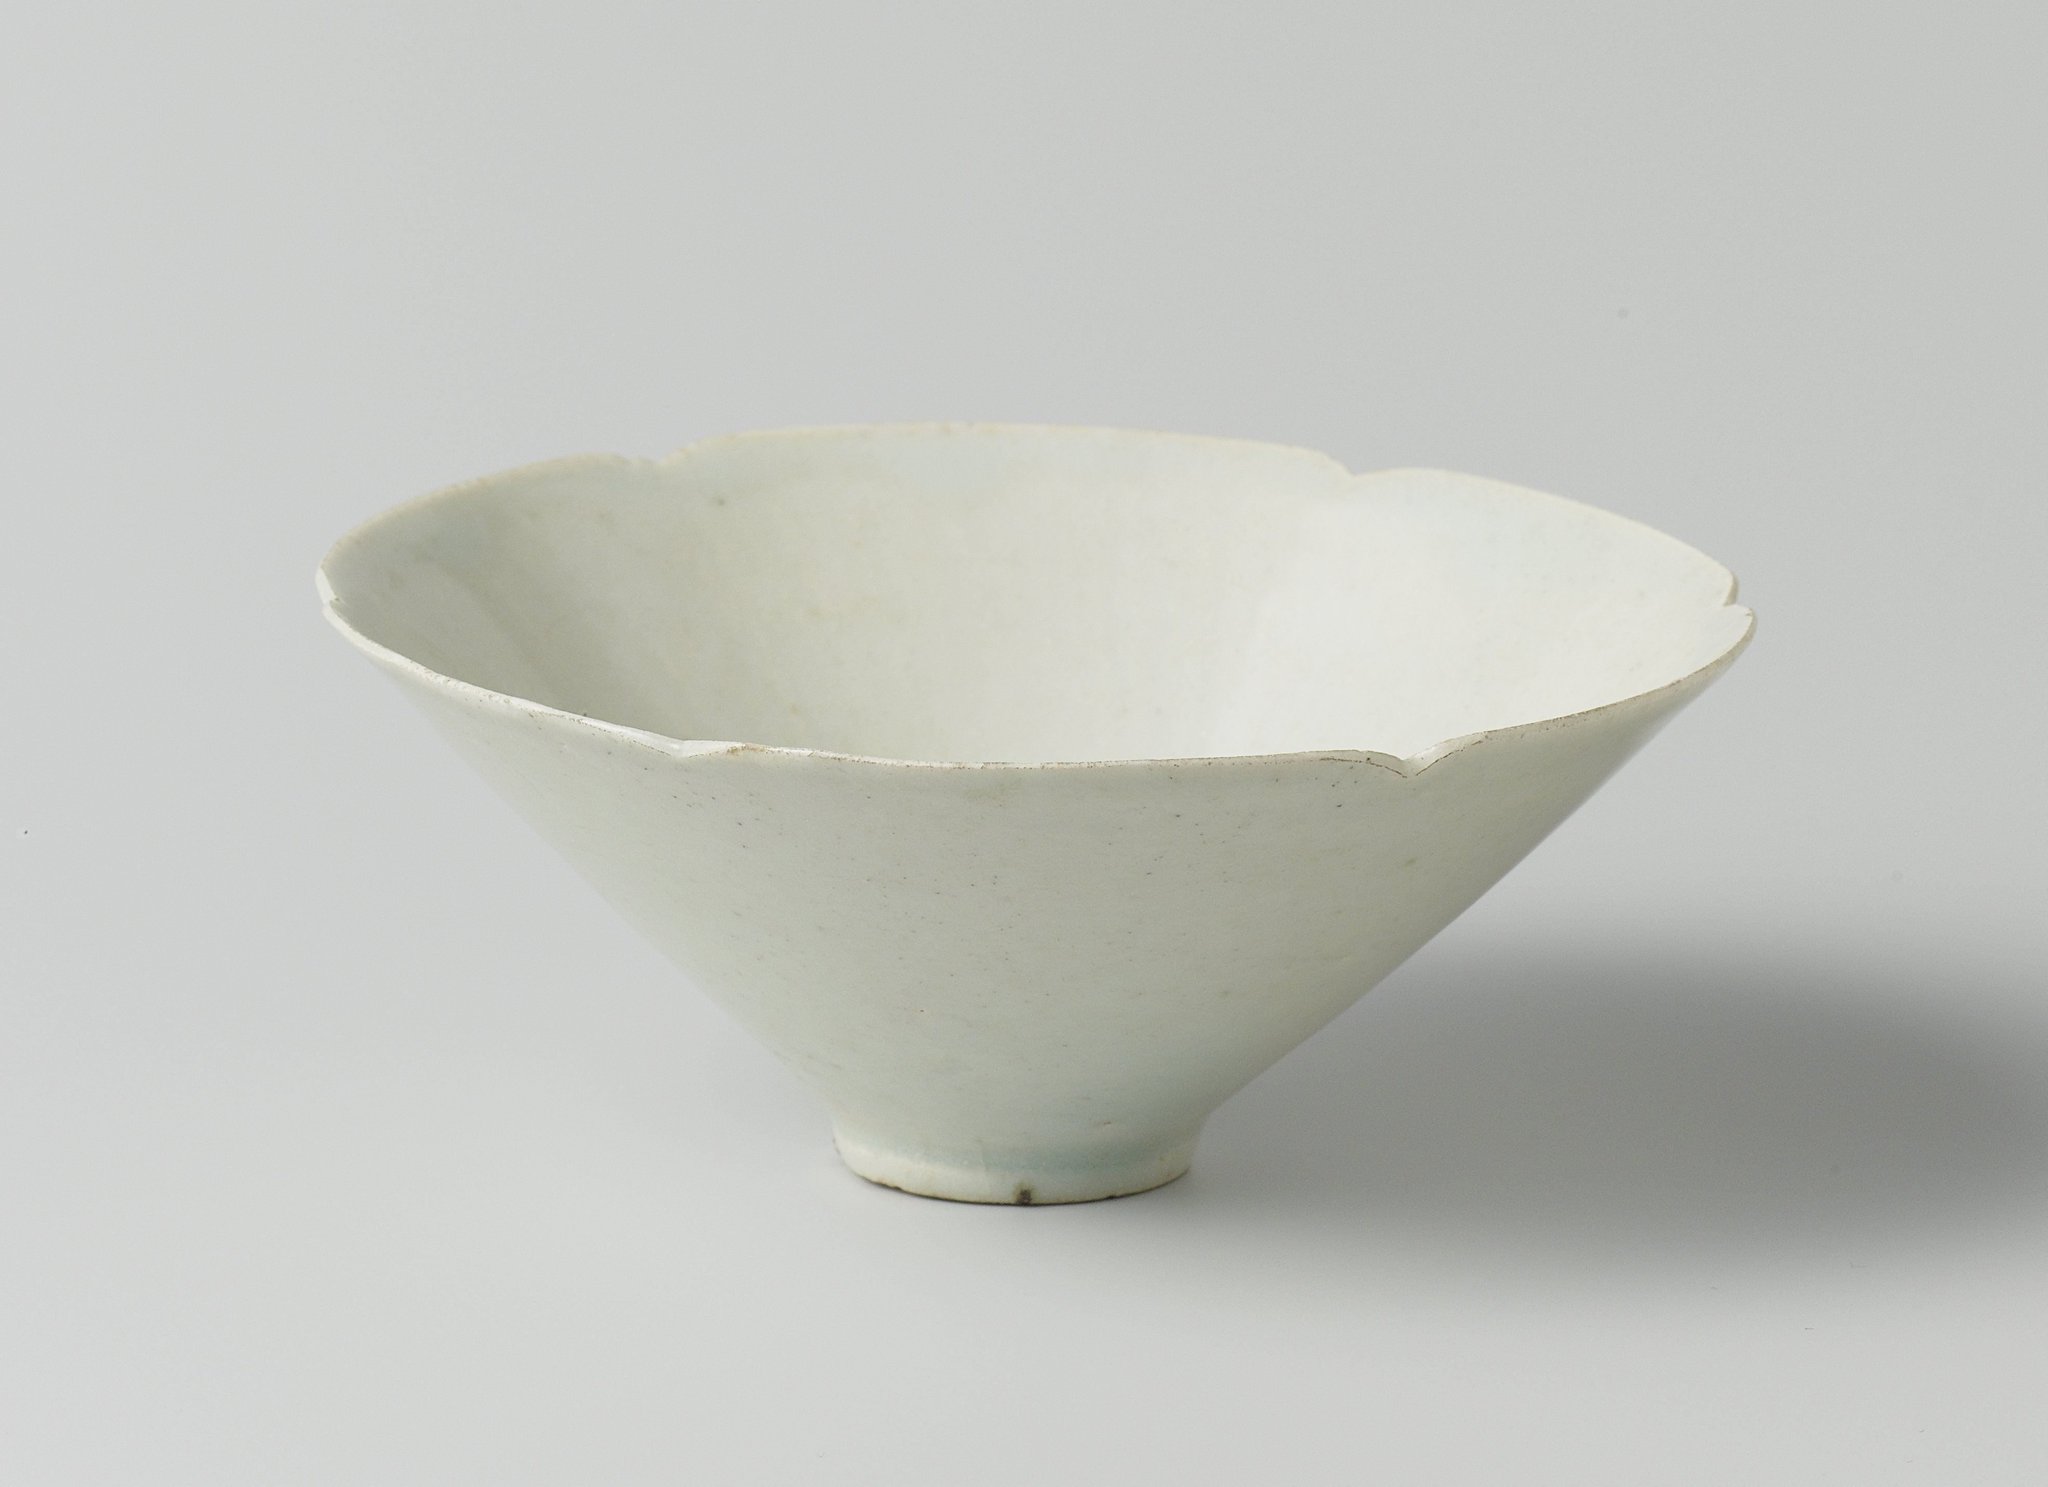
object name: bowl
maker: Anonymous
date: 960-1279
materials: glaze, stoneware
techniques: firing, forming, turning, vitrification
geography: china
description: Kom van steengoed met zesmaal gelobde rand, bedekt met een transparant glazuur met een lichtblauwe tint. De onderkant binnen de voetring ongeglazuurd. Qingbai.